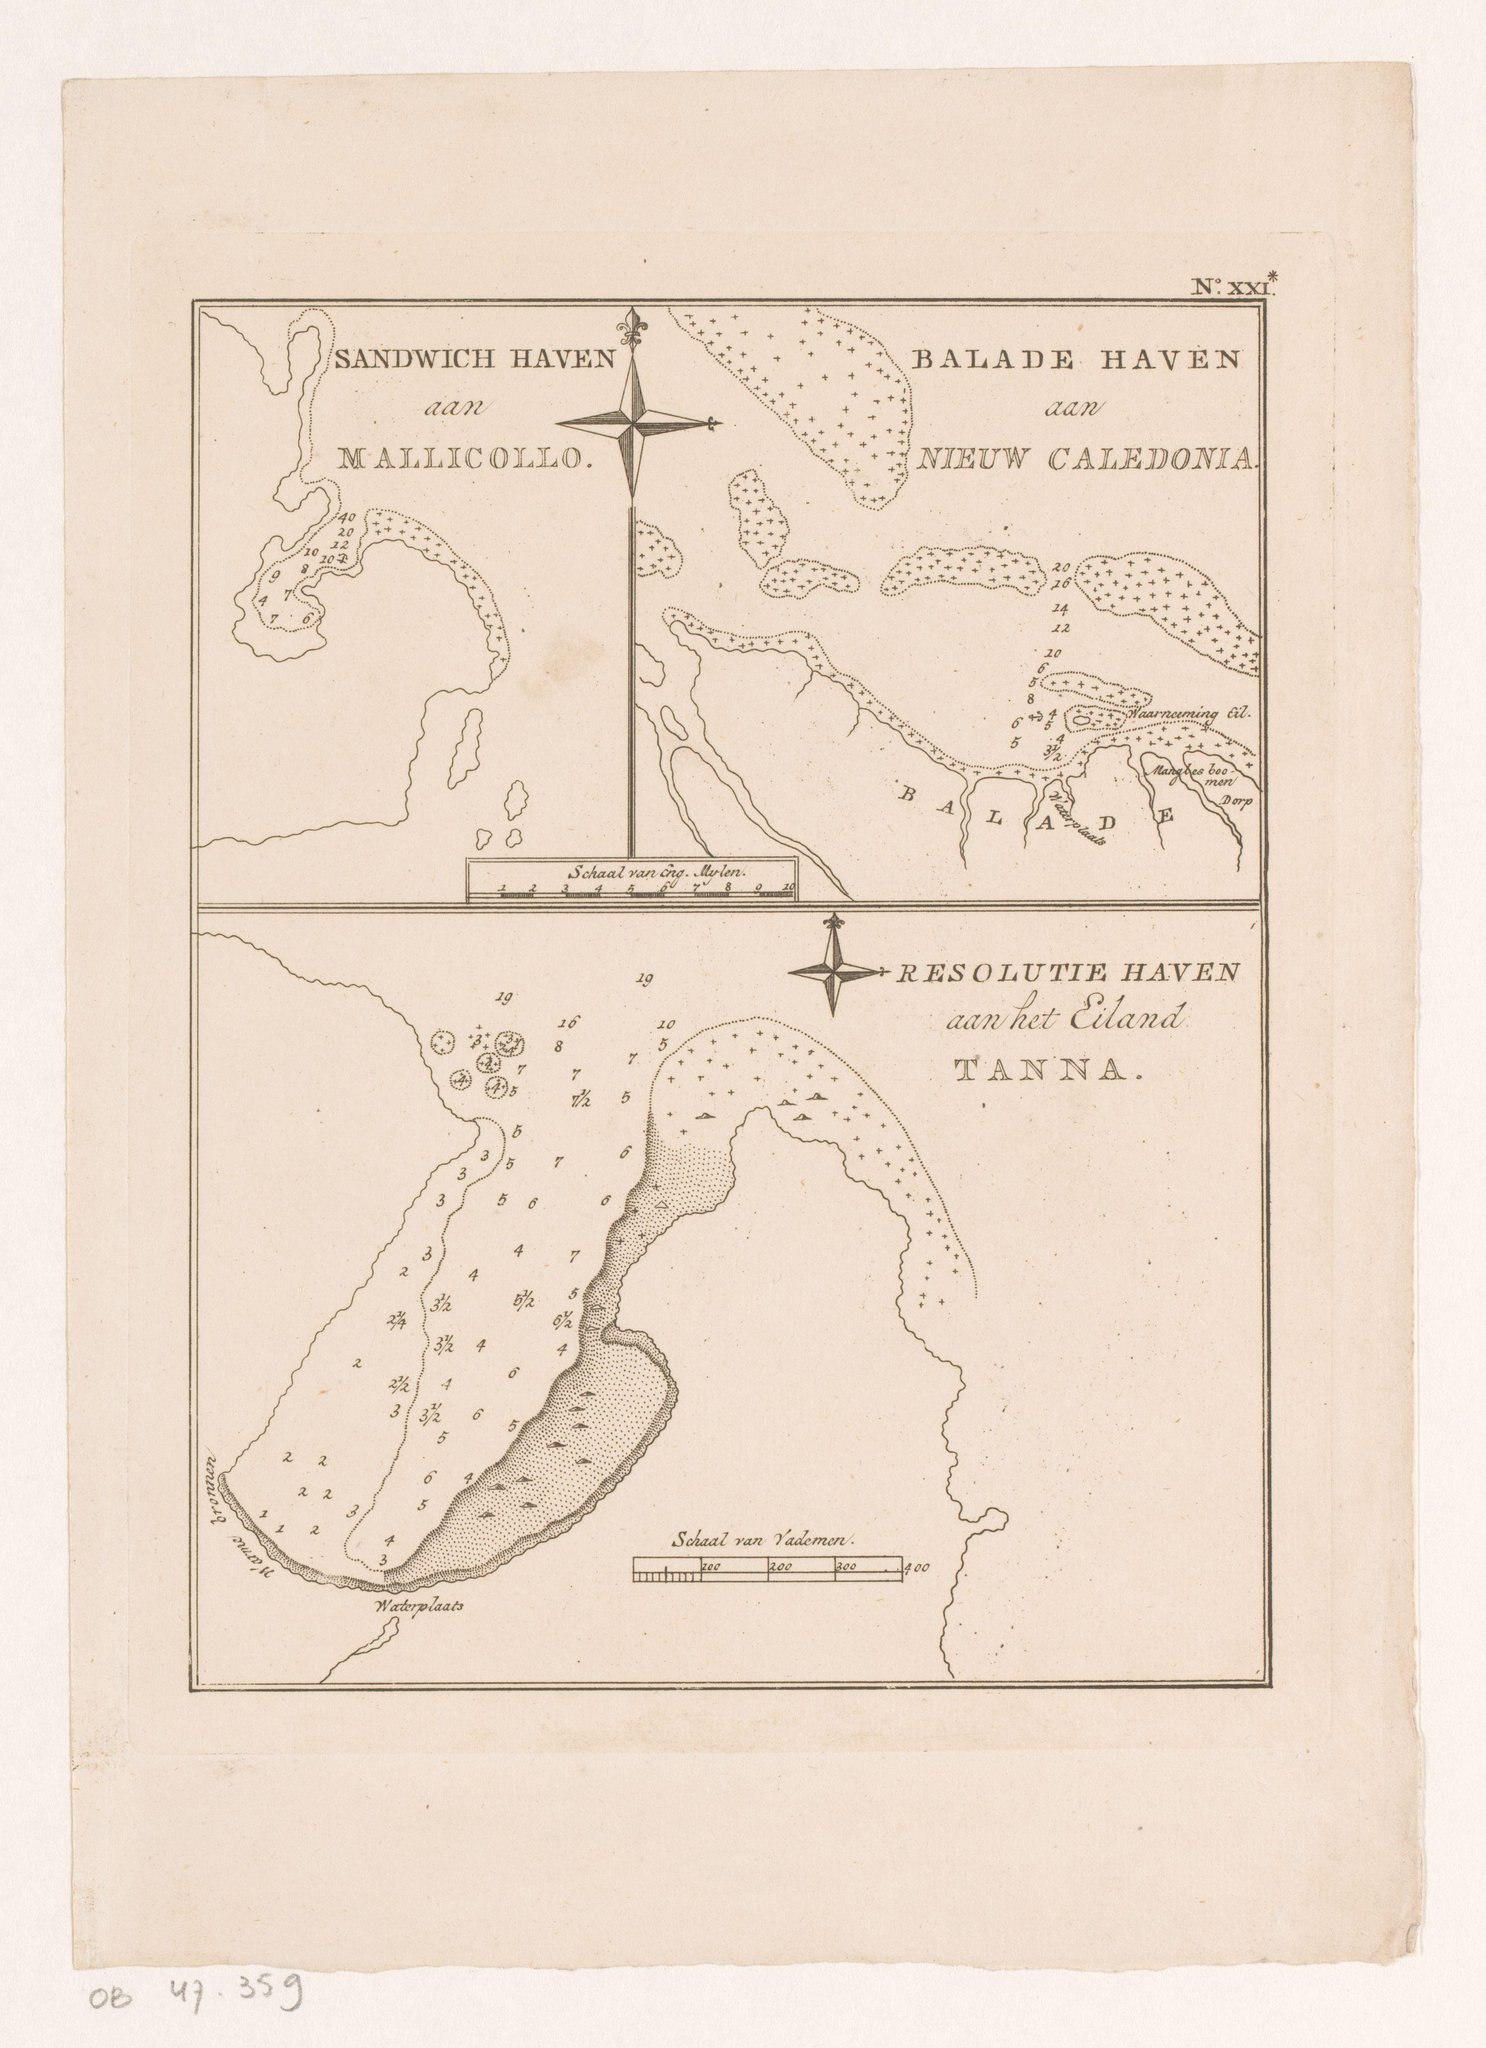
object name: print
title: Kaart van de kusten van de eilanden Malakula, Nieuw-Caledonië en Tanna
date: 1799-1800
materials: paper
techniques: etching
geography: amsterdam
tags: island, maps, atlases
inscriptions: collector's mark: Lugt 2228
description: Prent uit: Cook, James. Reize rondom de Waereld (...) met kaarten en plaaten. [Vertaald uit het Engels door] Jan David Pasteur. Leiden: Honkoop, Amsterdam: Allart, Den Haag: Van Cleef, 1799-1800, dl. 6, p. 169.